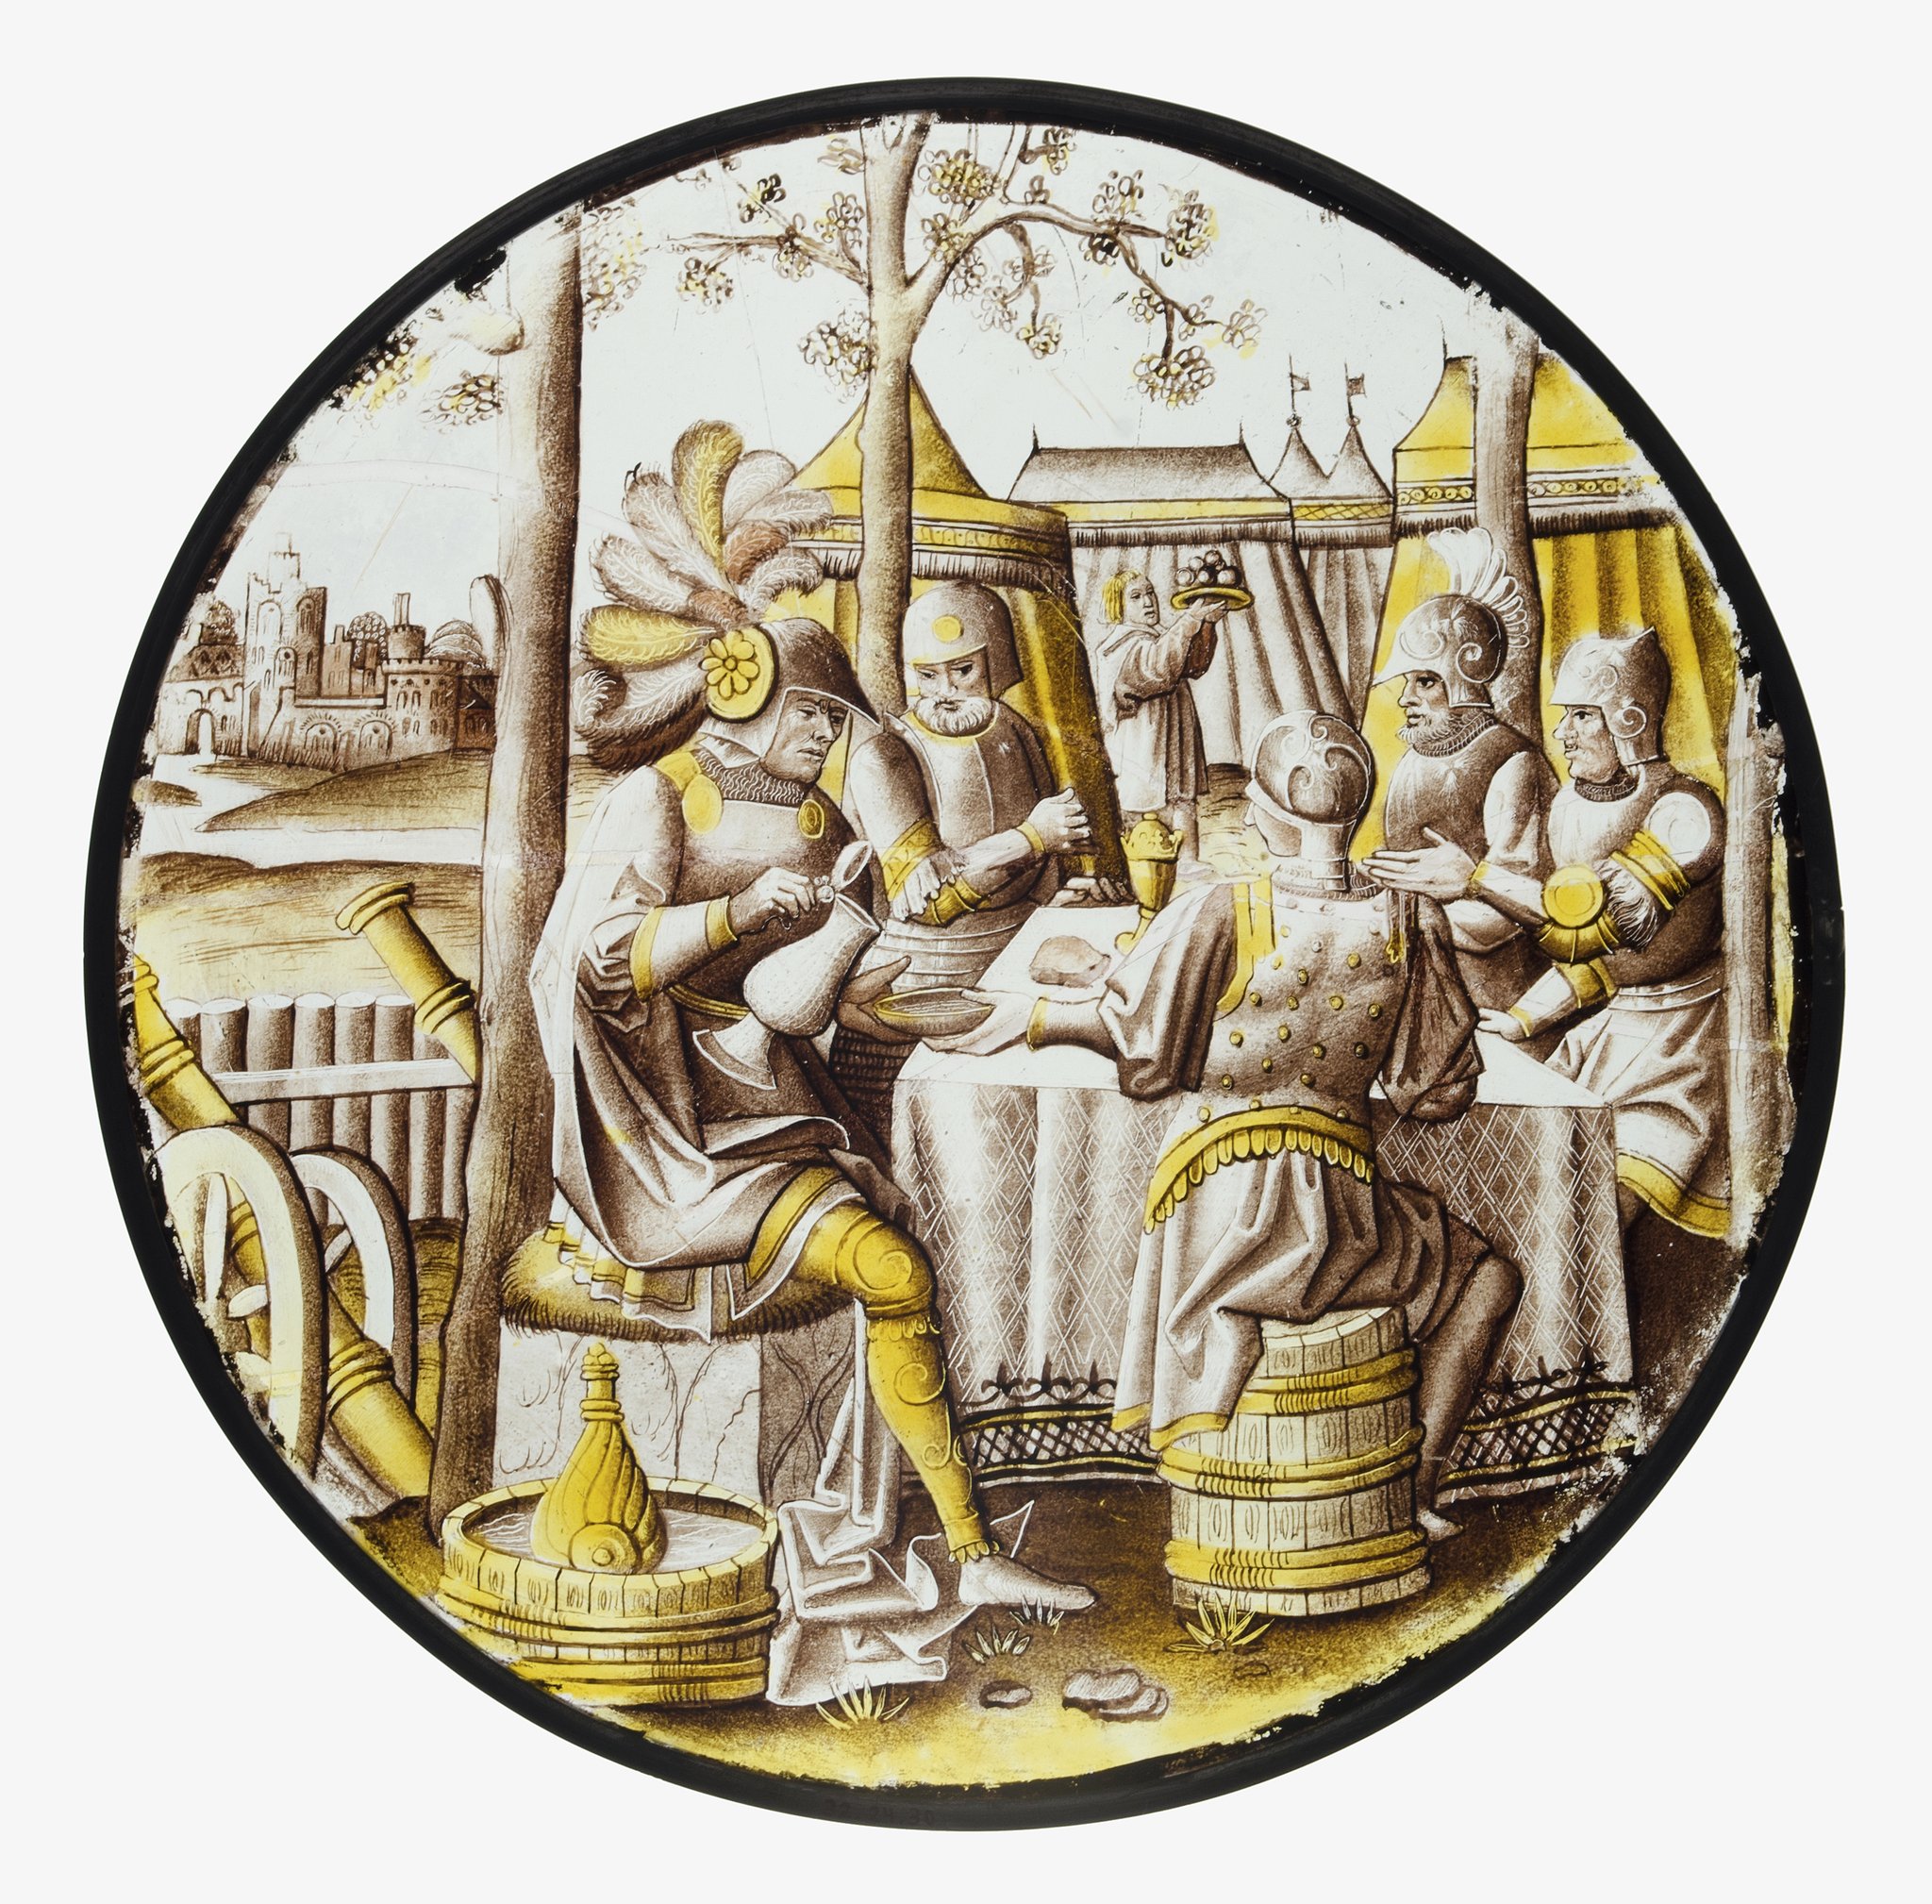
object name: roundel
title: Roundel with Ben-Hadid and the Siege of Samaria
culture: south netherlandish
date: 1525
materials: glass, paint, pigment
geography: south netherlands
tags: tents,soldiers,cannons,men,drinking,tables